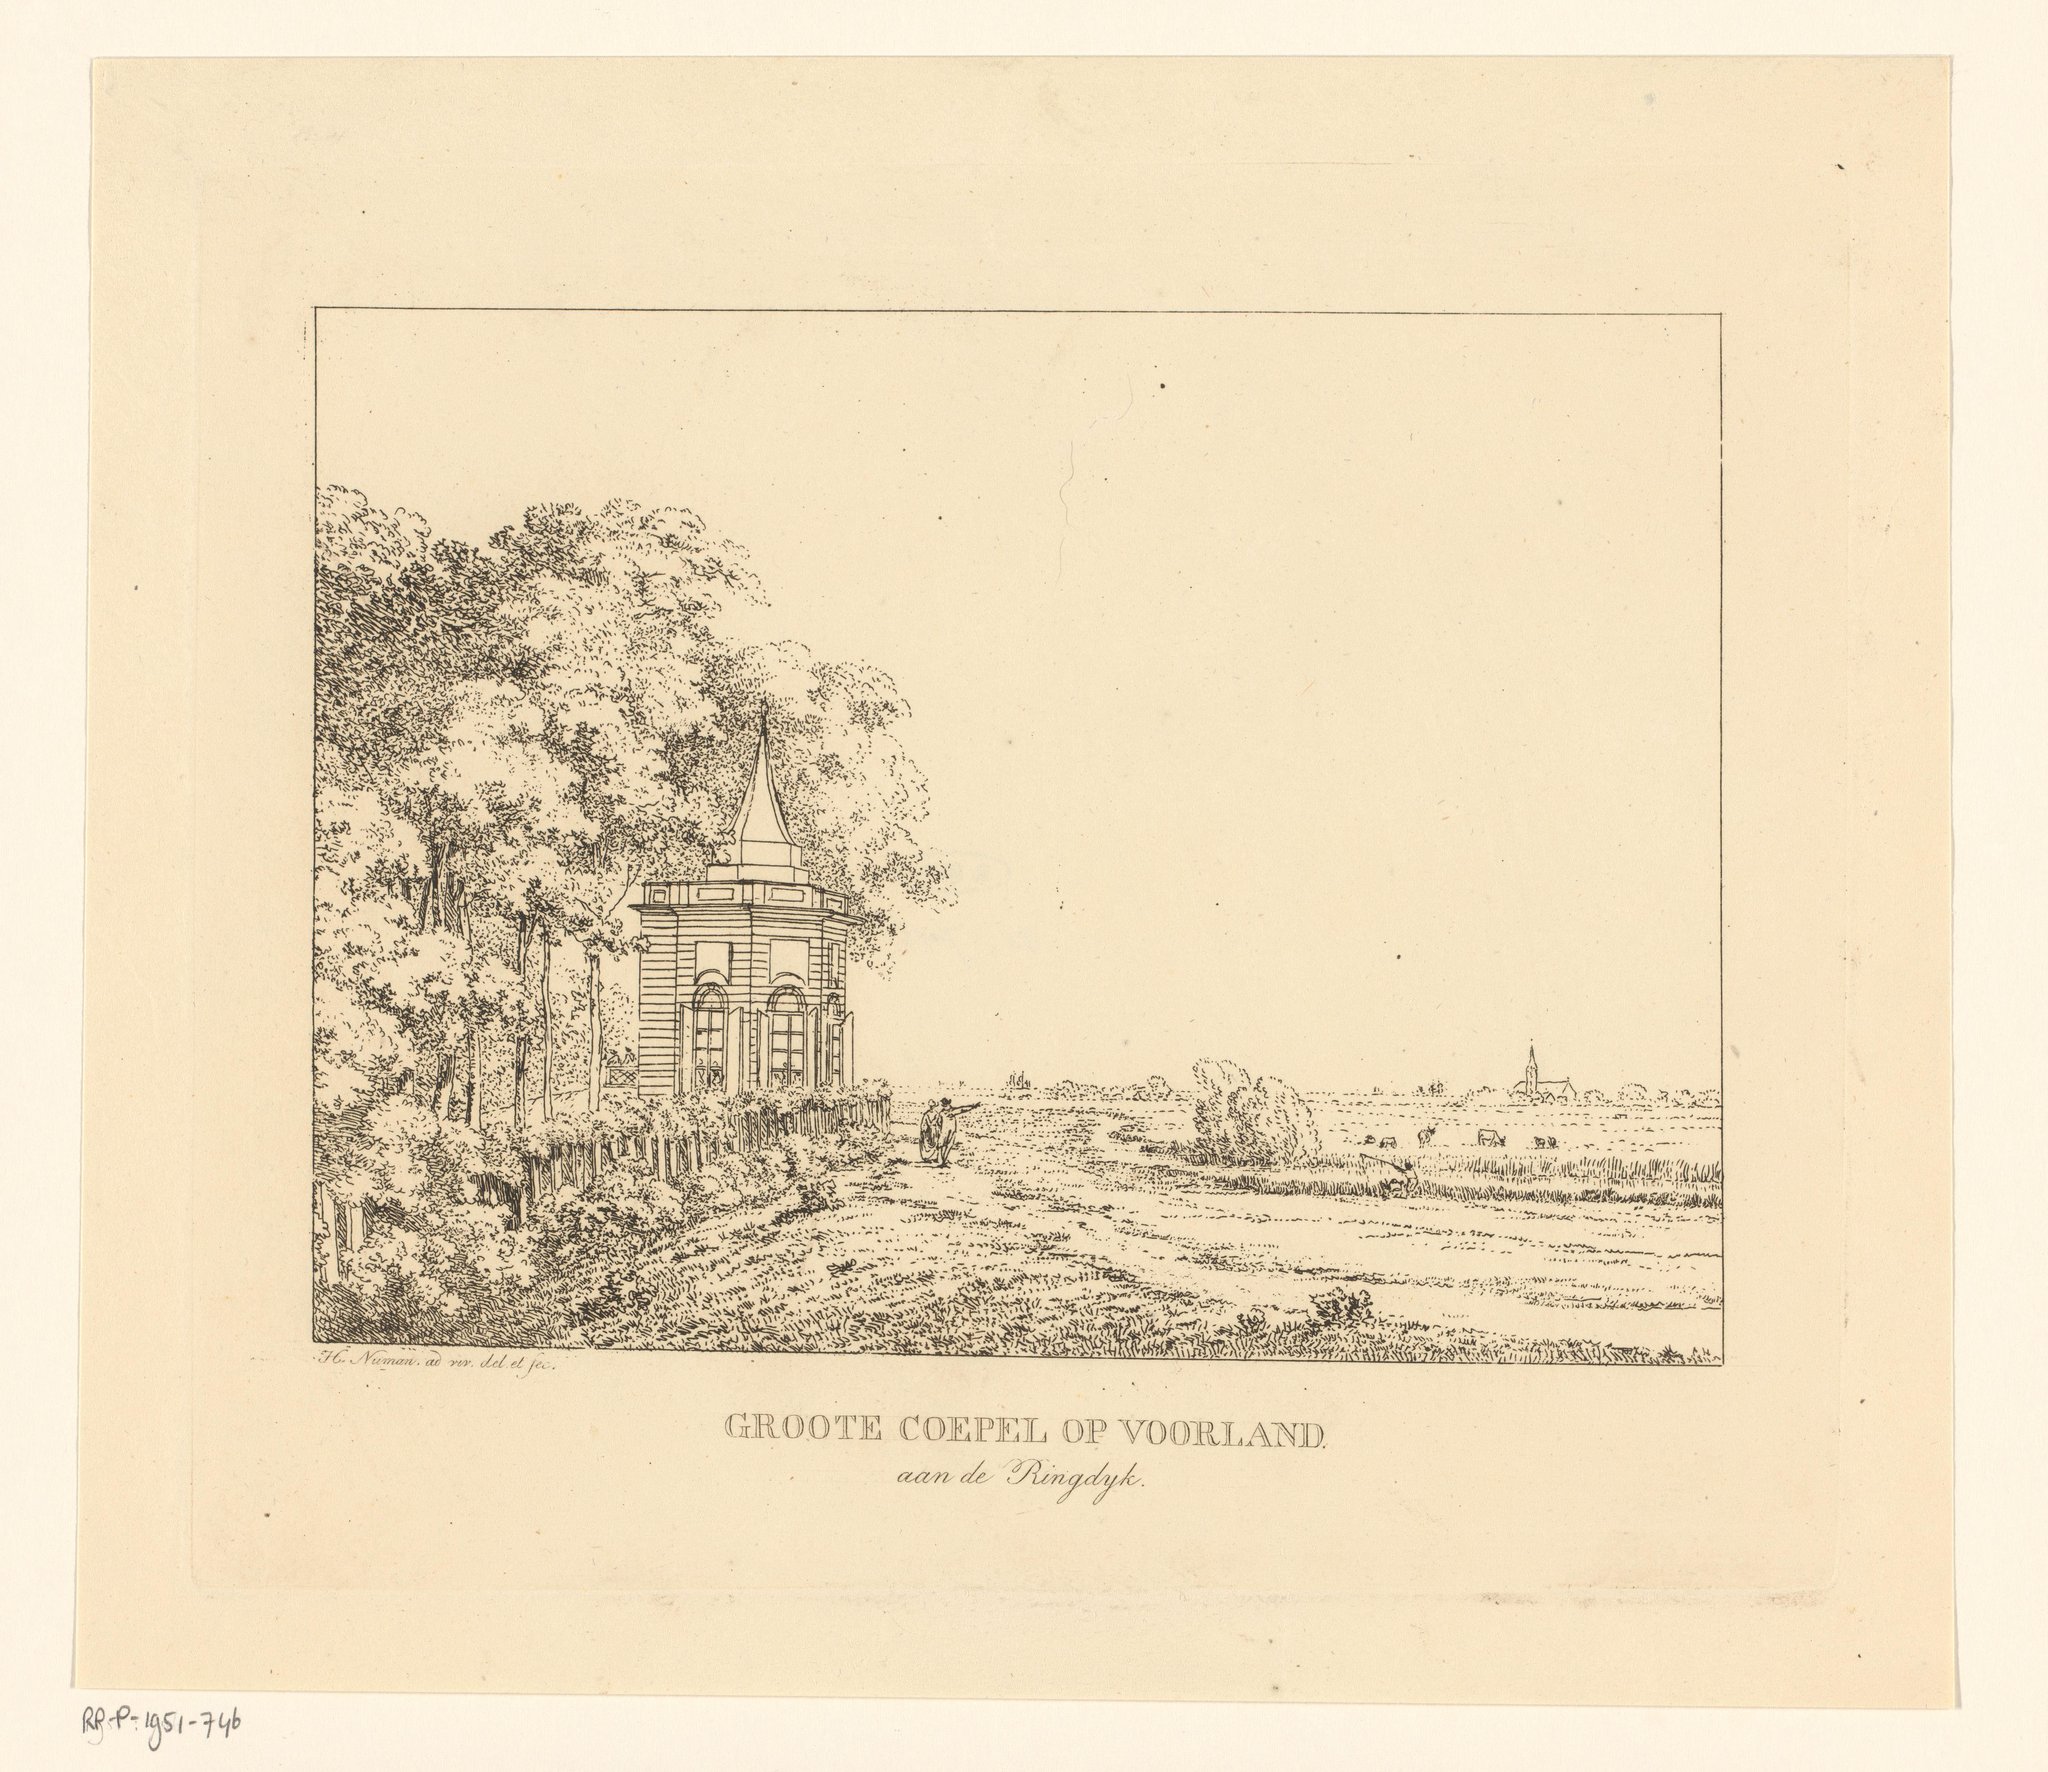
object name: print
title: Koepel van Voorland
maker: hermanus numan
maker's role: draughtsman, painter, print maker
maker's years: 1744-1820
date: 1794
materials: paper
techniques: etching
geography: netherlands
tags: country-house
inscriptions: collector's mark: Lugt 2228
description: Prent ook gebruikt in: Numan, Hermanus. Vierentwintig printtekeningen met couleuren, verbeeldende Hollandsche buitenplaatzen. Amsterdam: Jan IJver, Jan Willem Smit en Hermanus Numan, 1797.